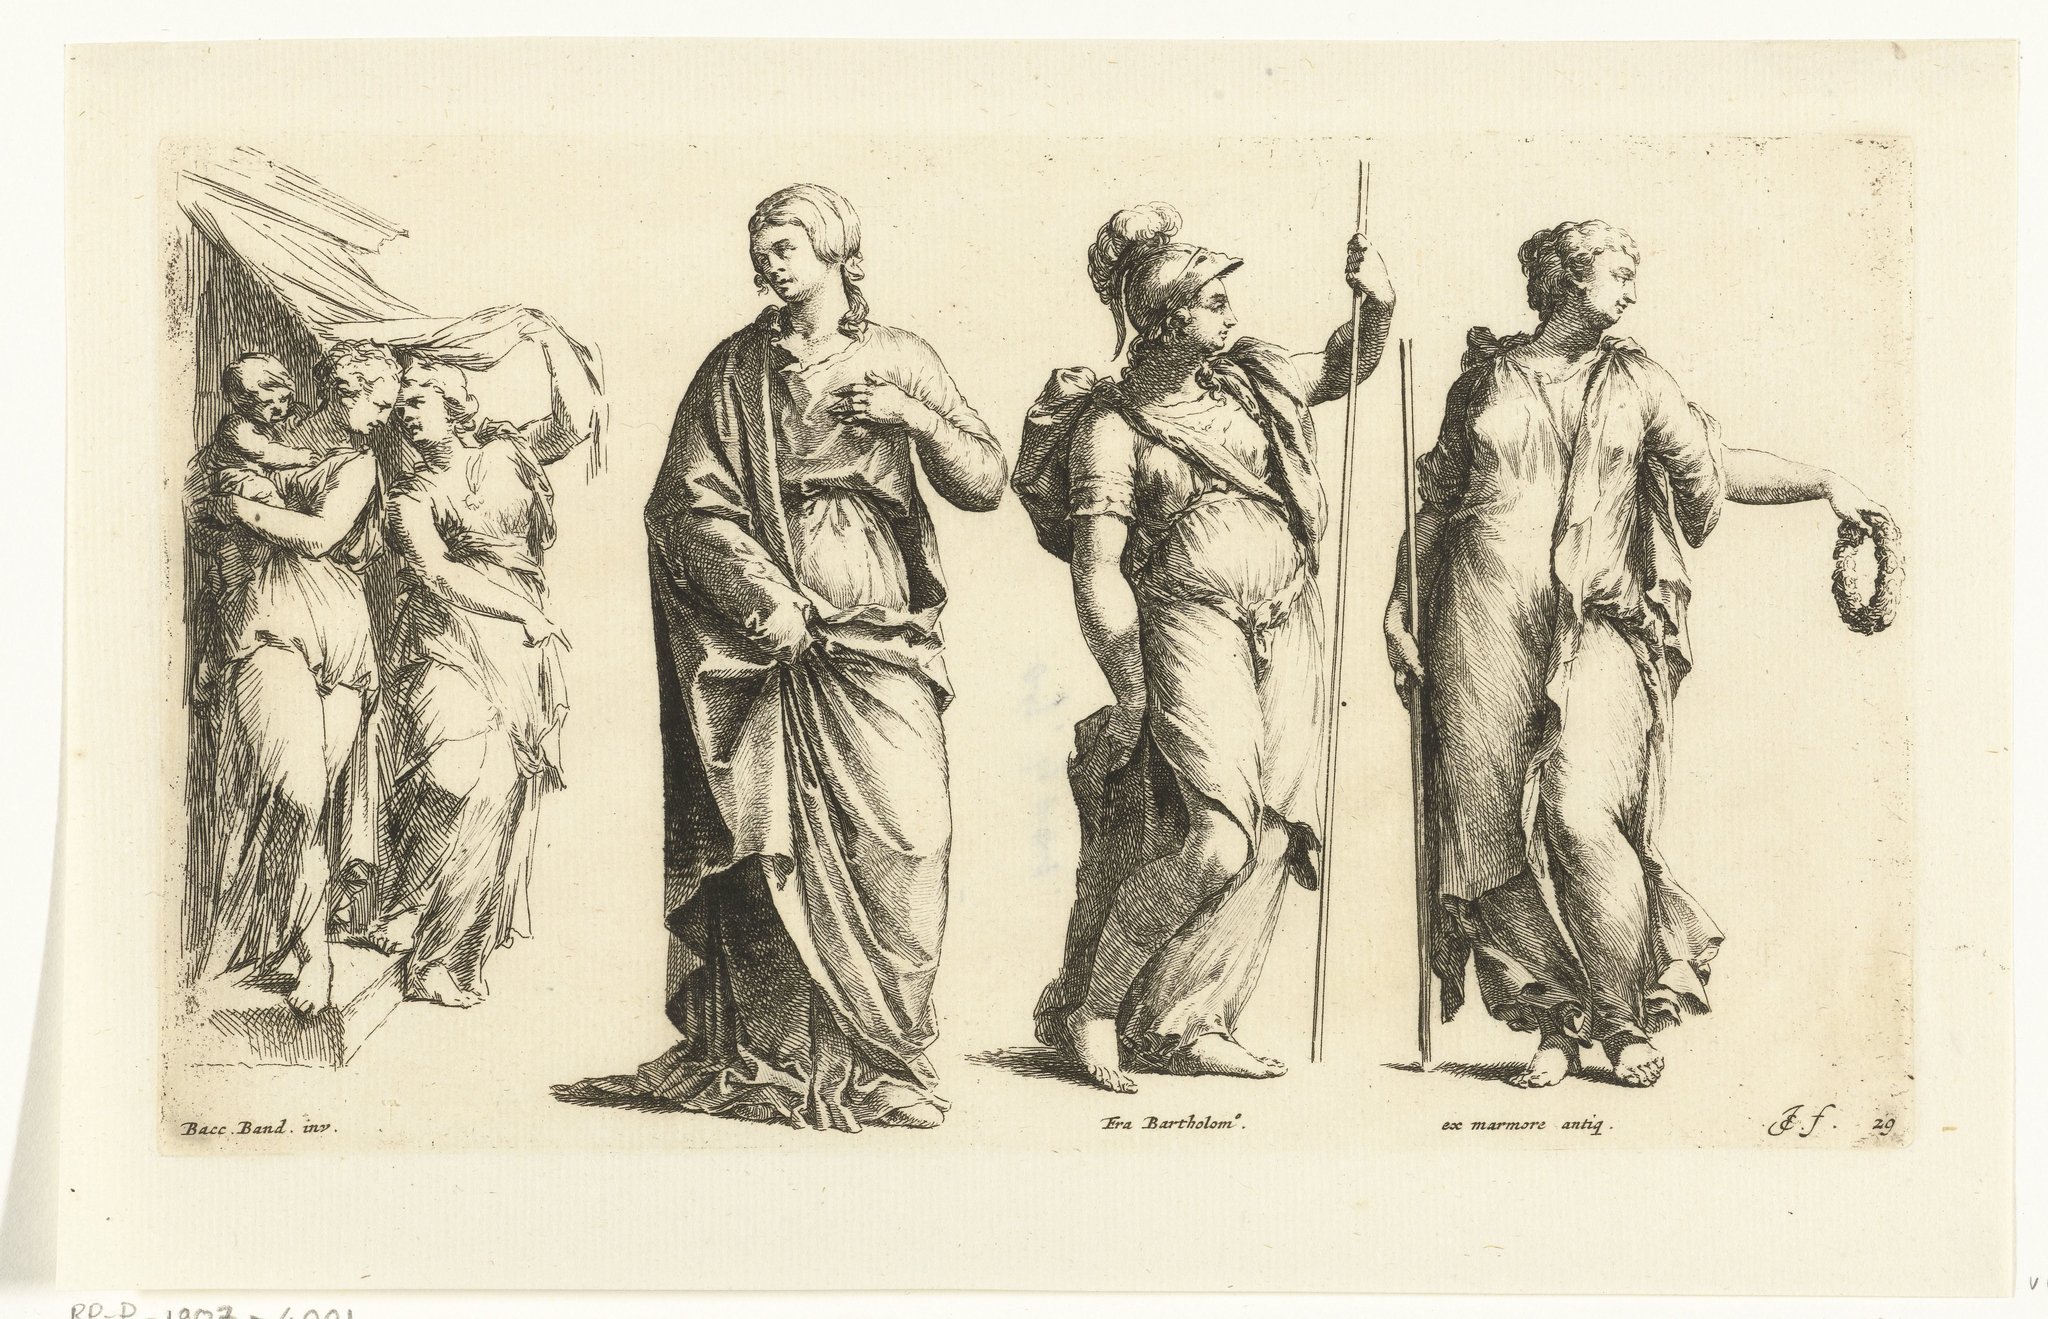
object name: print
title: Drie vrouwenbeelden en een groep met twee vrouwen en een kind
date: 1668-1671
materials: paper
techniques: etching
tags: (story of) minerva (pallas, athena), (story of) flora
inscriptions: collector's mark: Lugt 2228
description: Geheel links een groep van twee vrouwen, de ene houdt een kind op haar arm (a). Ernaast een vrouw die haar rok omhoog houdt (b). In het midden rechts Minerva (?, c). Geheel rechts een beeld dat verschillende figuren zou kunnen vorstellen, mogelijk een muze, of de godin Flora, of Laetitia publica (d).